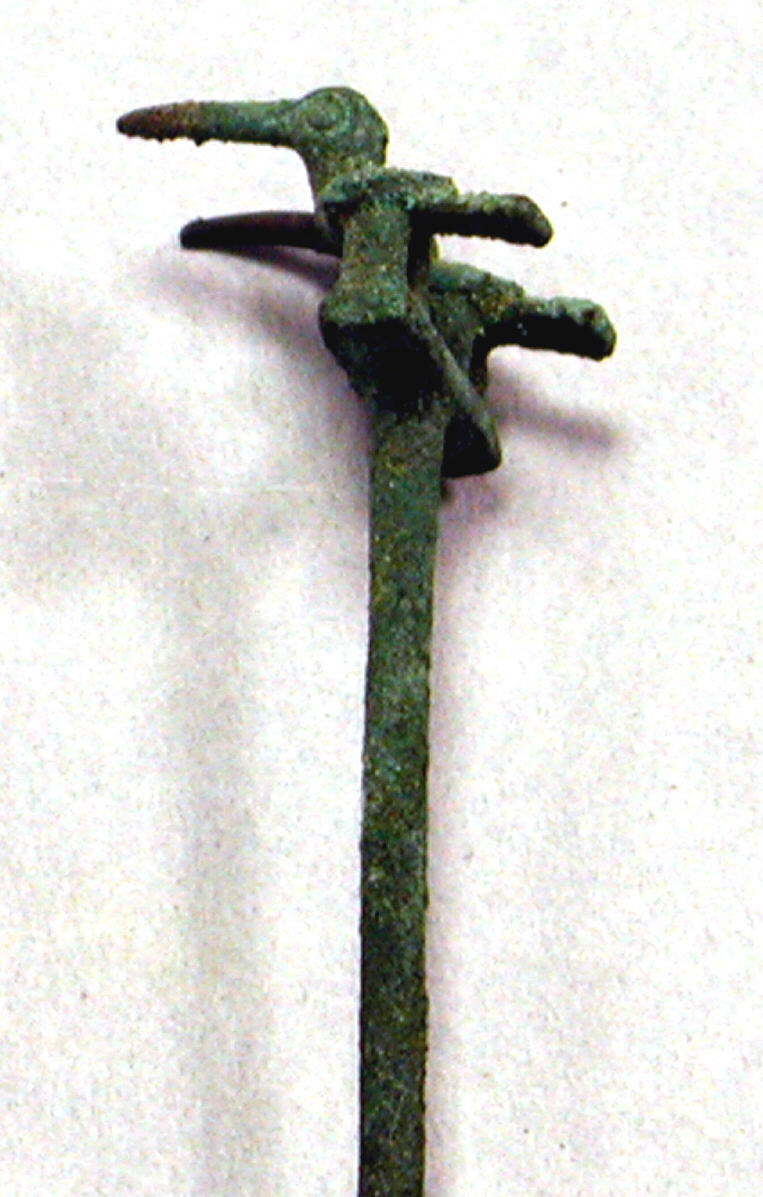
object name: pin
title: Tupu (pin)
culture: inca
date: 1400-1533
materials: copper alloy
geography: peru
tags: birds